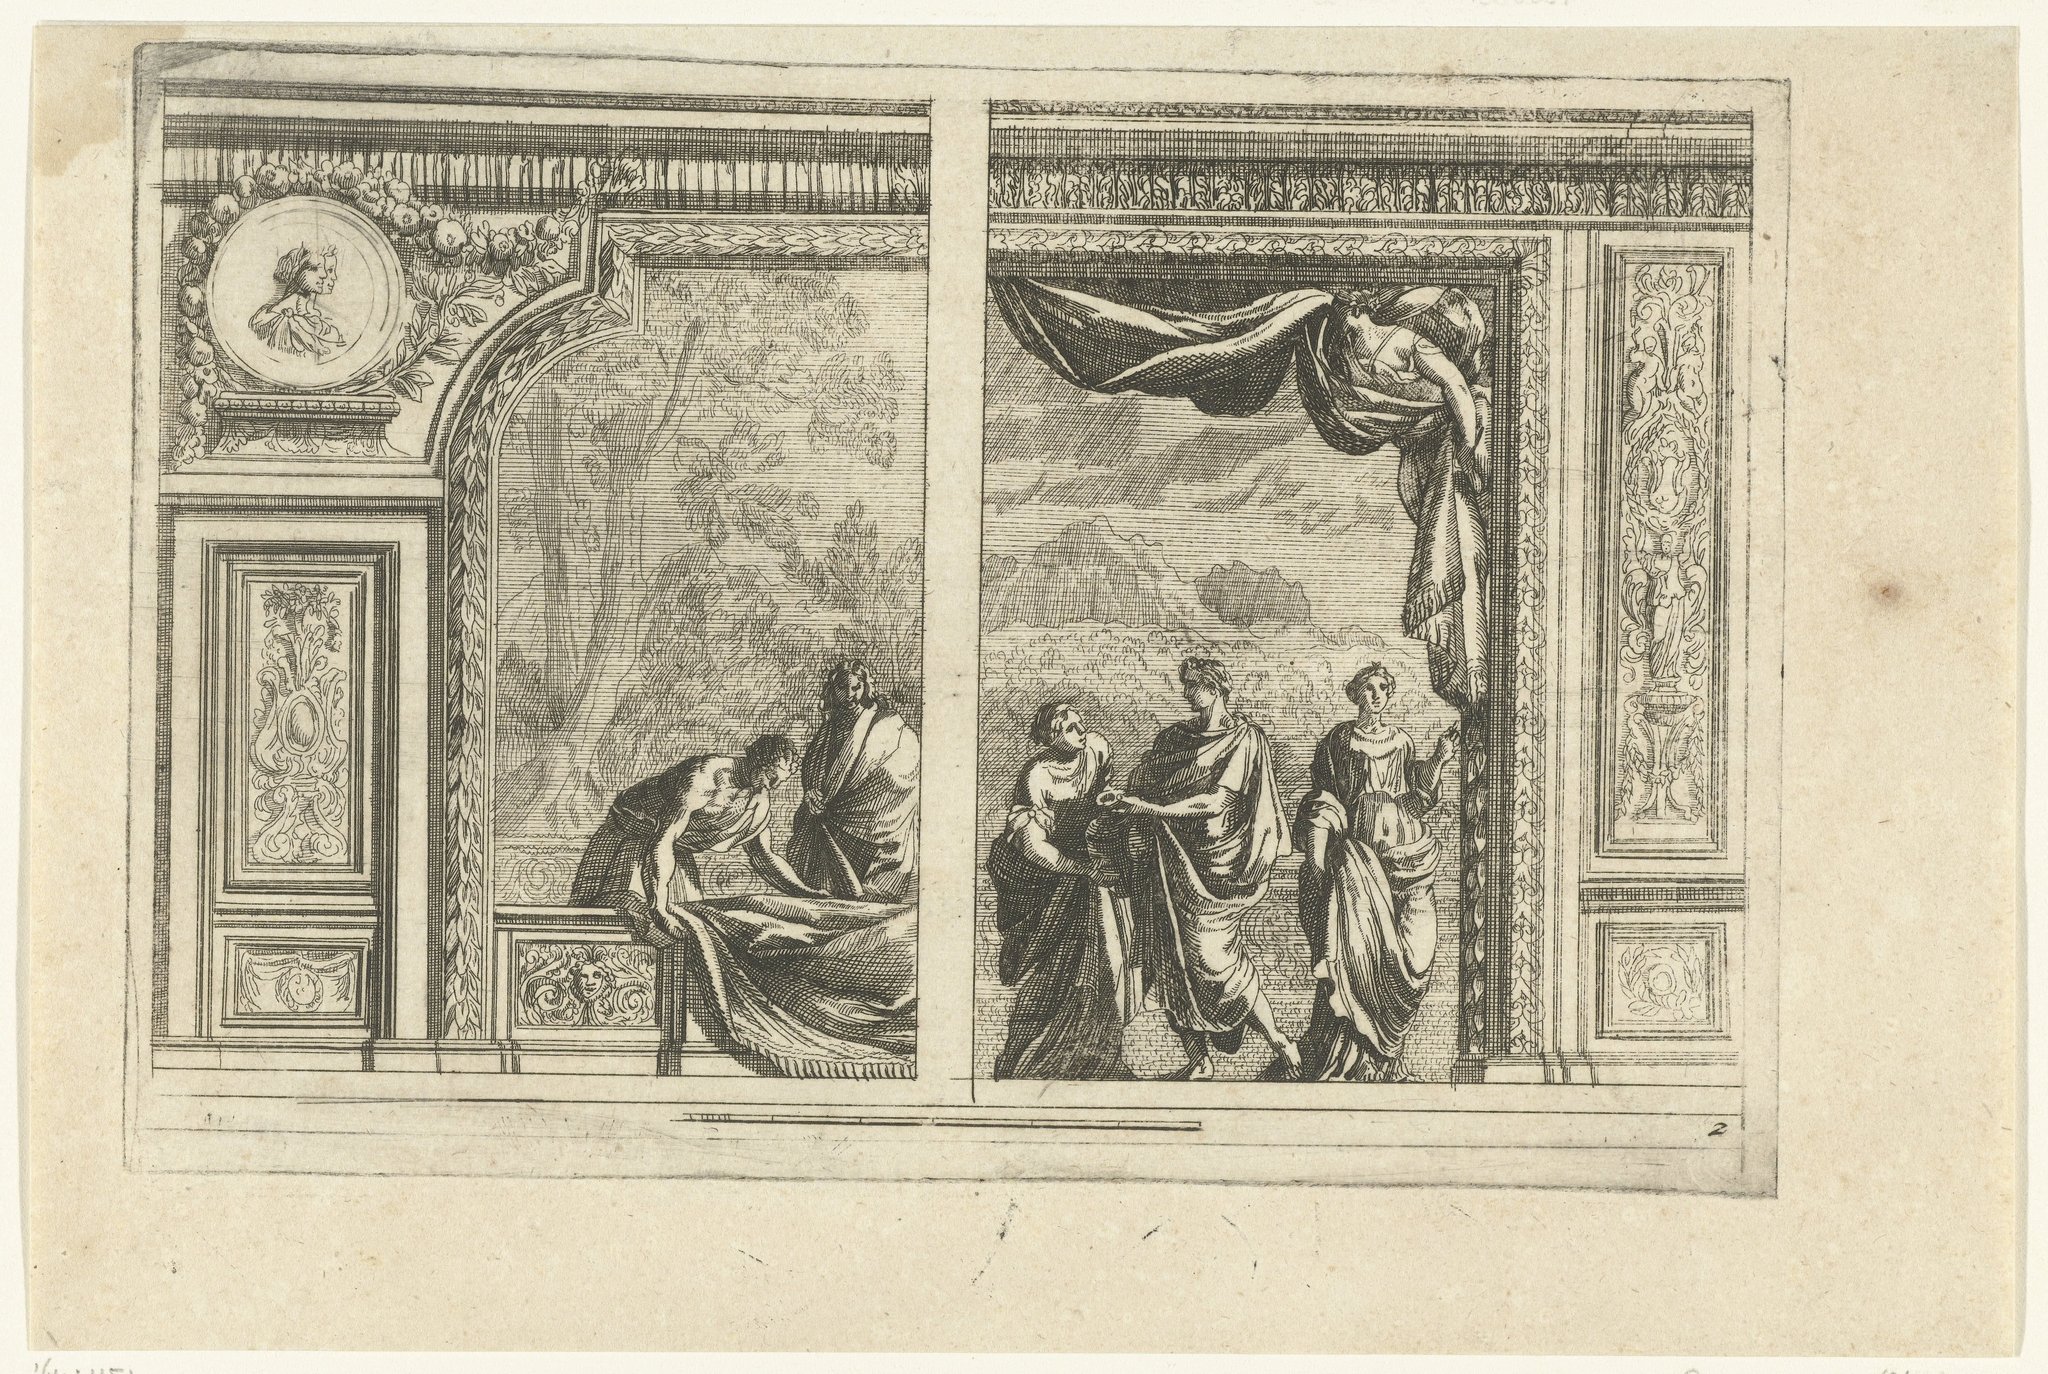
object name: print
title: Alkoven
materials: paper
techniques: etching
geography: netherlands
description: Links staan twee en rechts drie figuren.